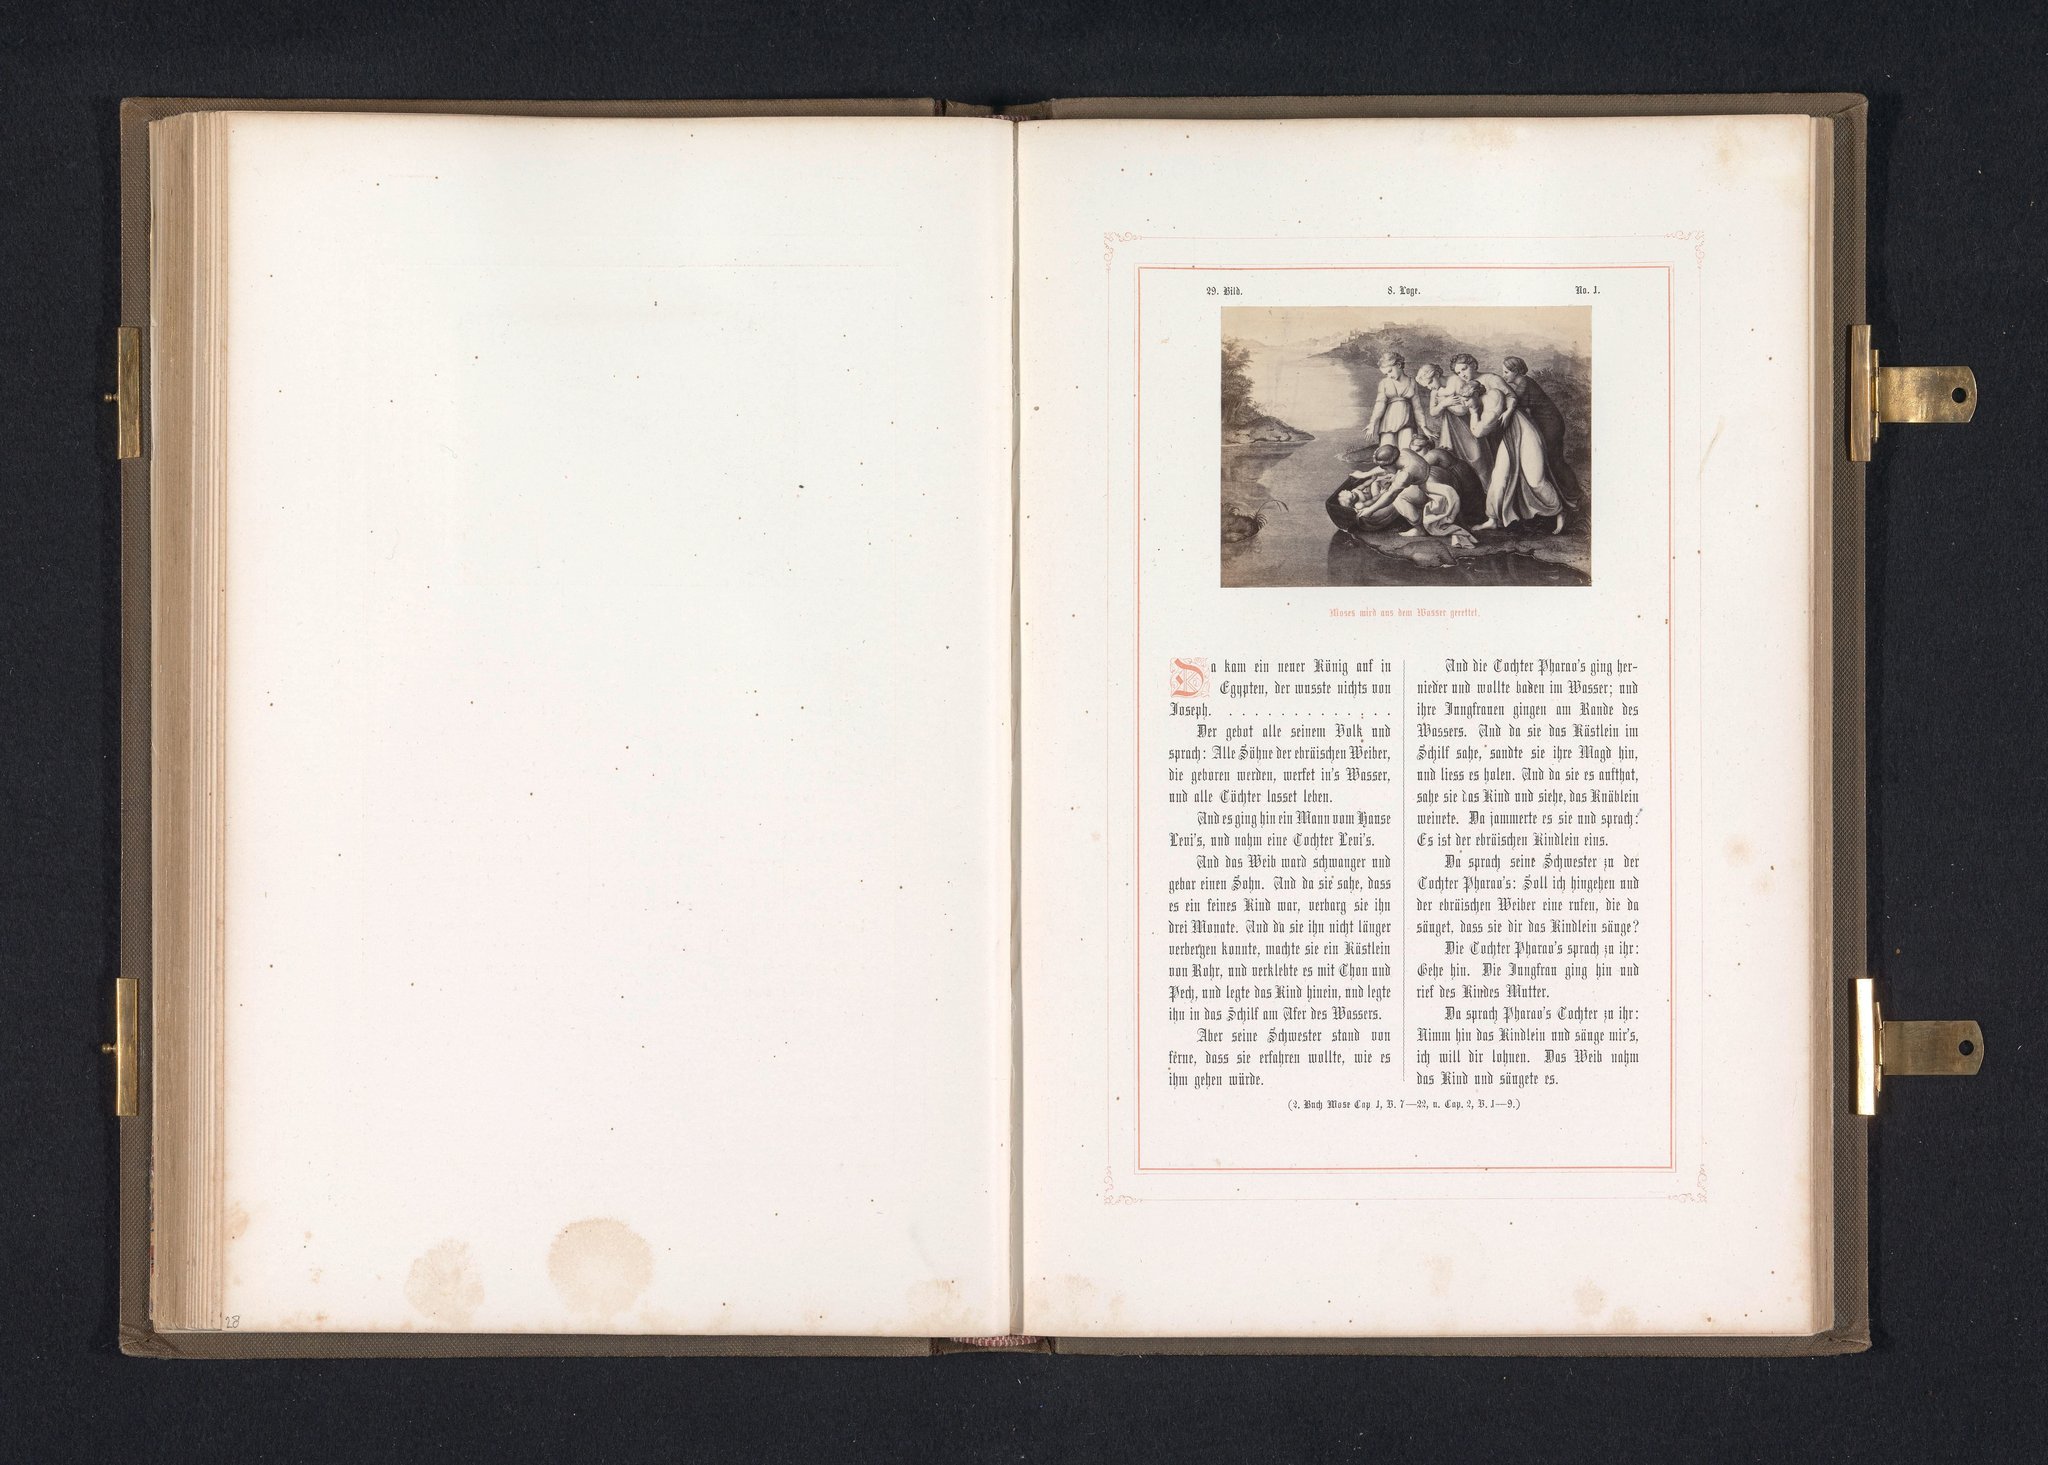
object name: page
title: Fotoreproductie van een prent naar een fresco van Moses gevonden op de Nijl door Rafaël voor de loggia's in het Vaticaan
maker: gustav schauer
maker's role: painter, publisher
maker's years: 1826-1902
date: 1851-1861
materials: photographic support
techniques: albumen print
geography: berlin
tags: the finding of moses: pharaoh's daughter comes to bathe with her maidens in the river and discovers the child floating on the water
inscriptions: inscription: ‘29. Bild. 8. Loge. No. 1.’